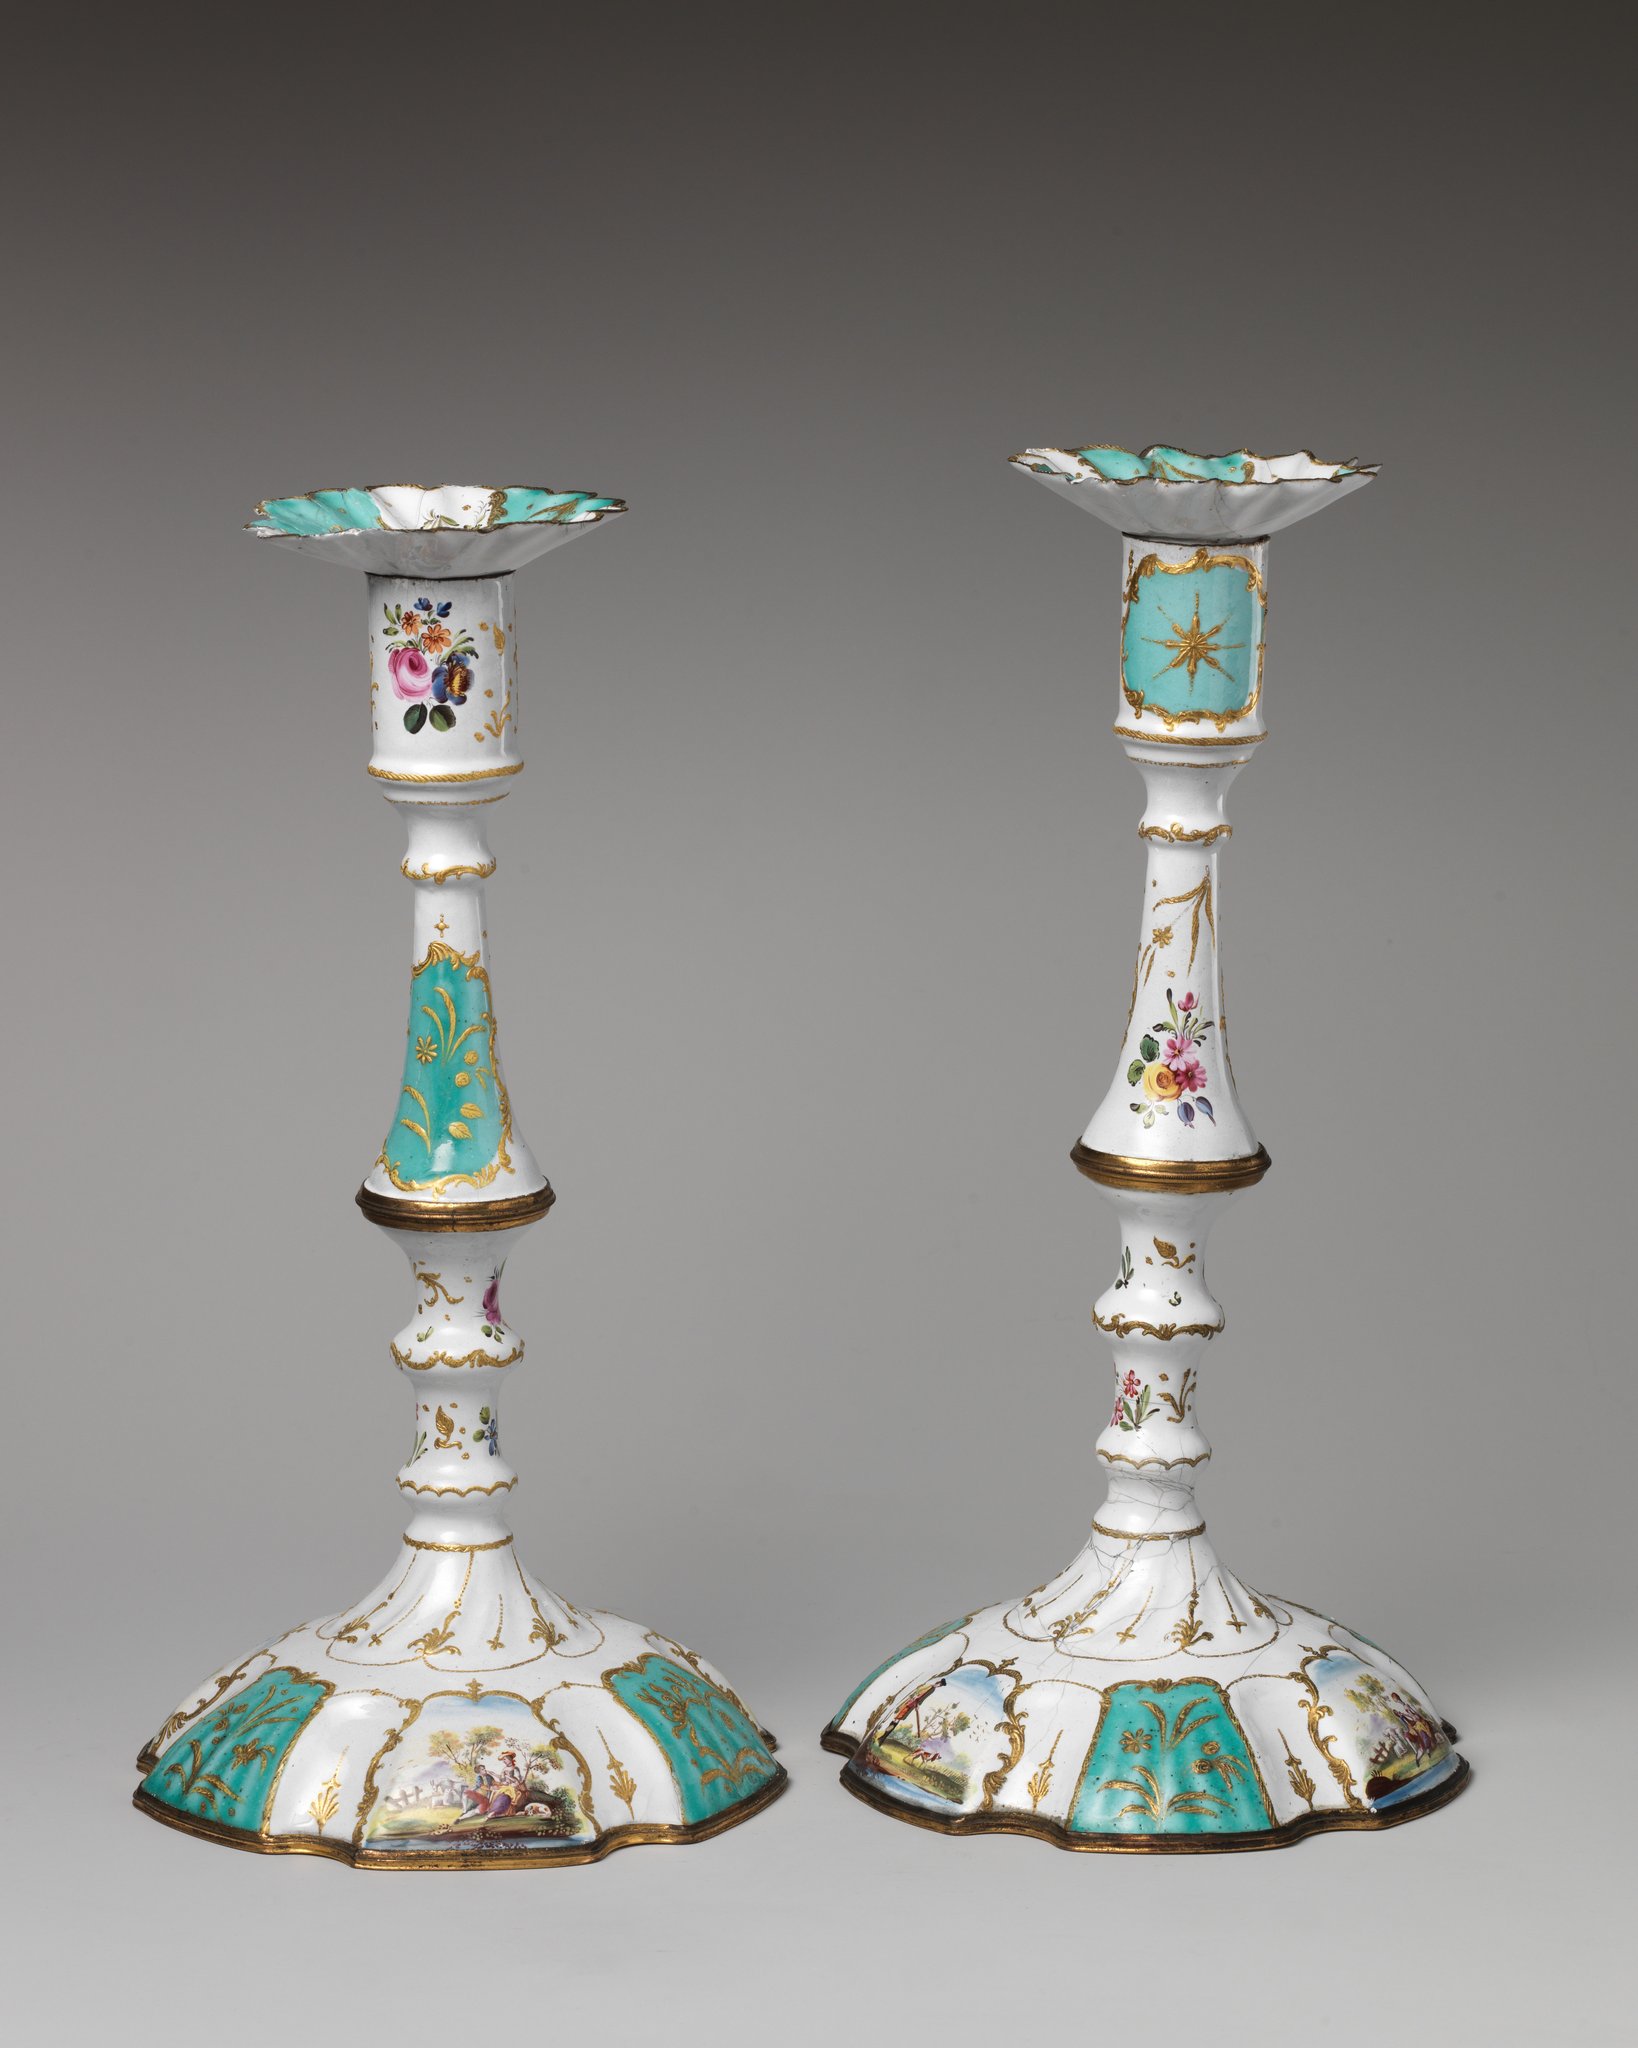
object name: candlestick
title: Pair of candlesticks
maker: robert sayer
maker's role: publisher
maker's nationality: british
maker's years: 1725-1794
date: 1765-1775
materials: enamel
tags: men,women,trees